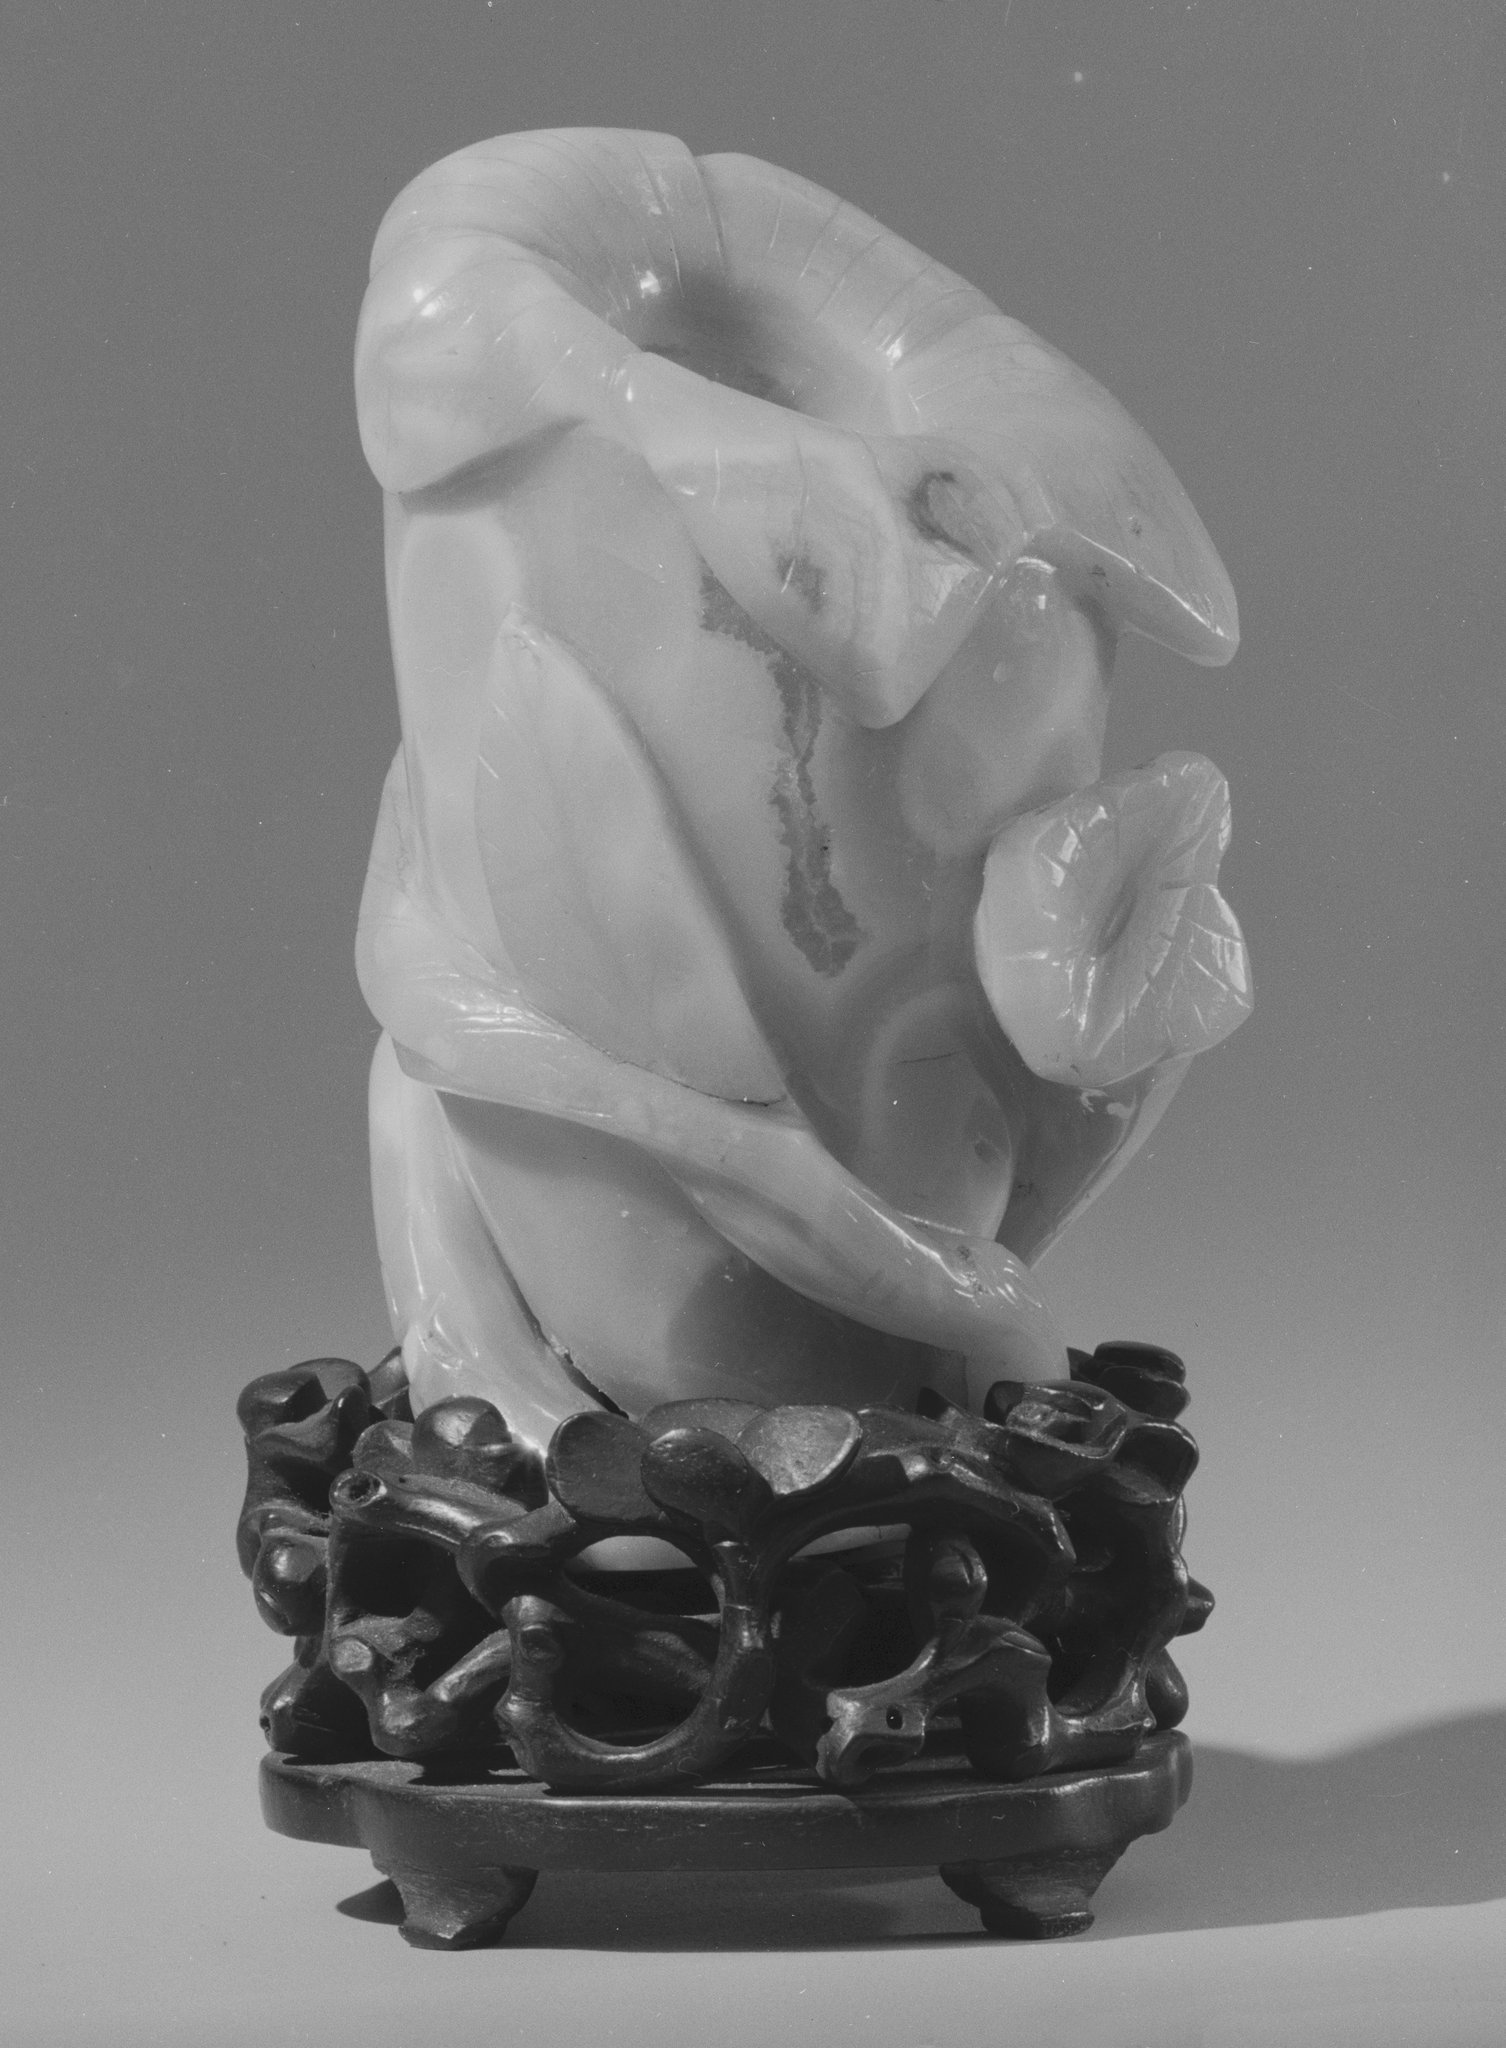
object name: flower holder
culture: chinese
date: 1867-1900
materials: stone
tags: flowers